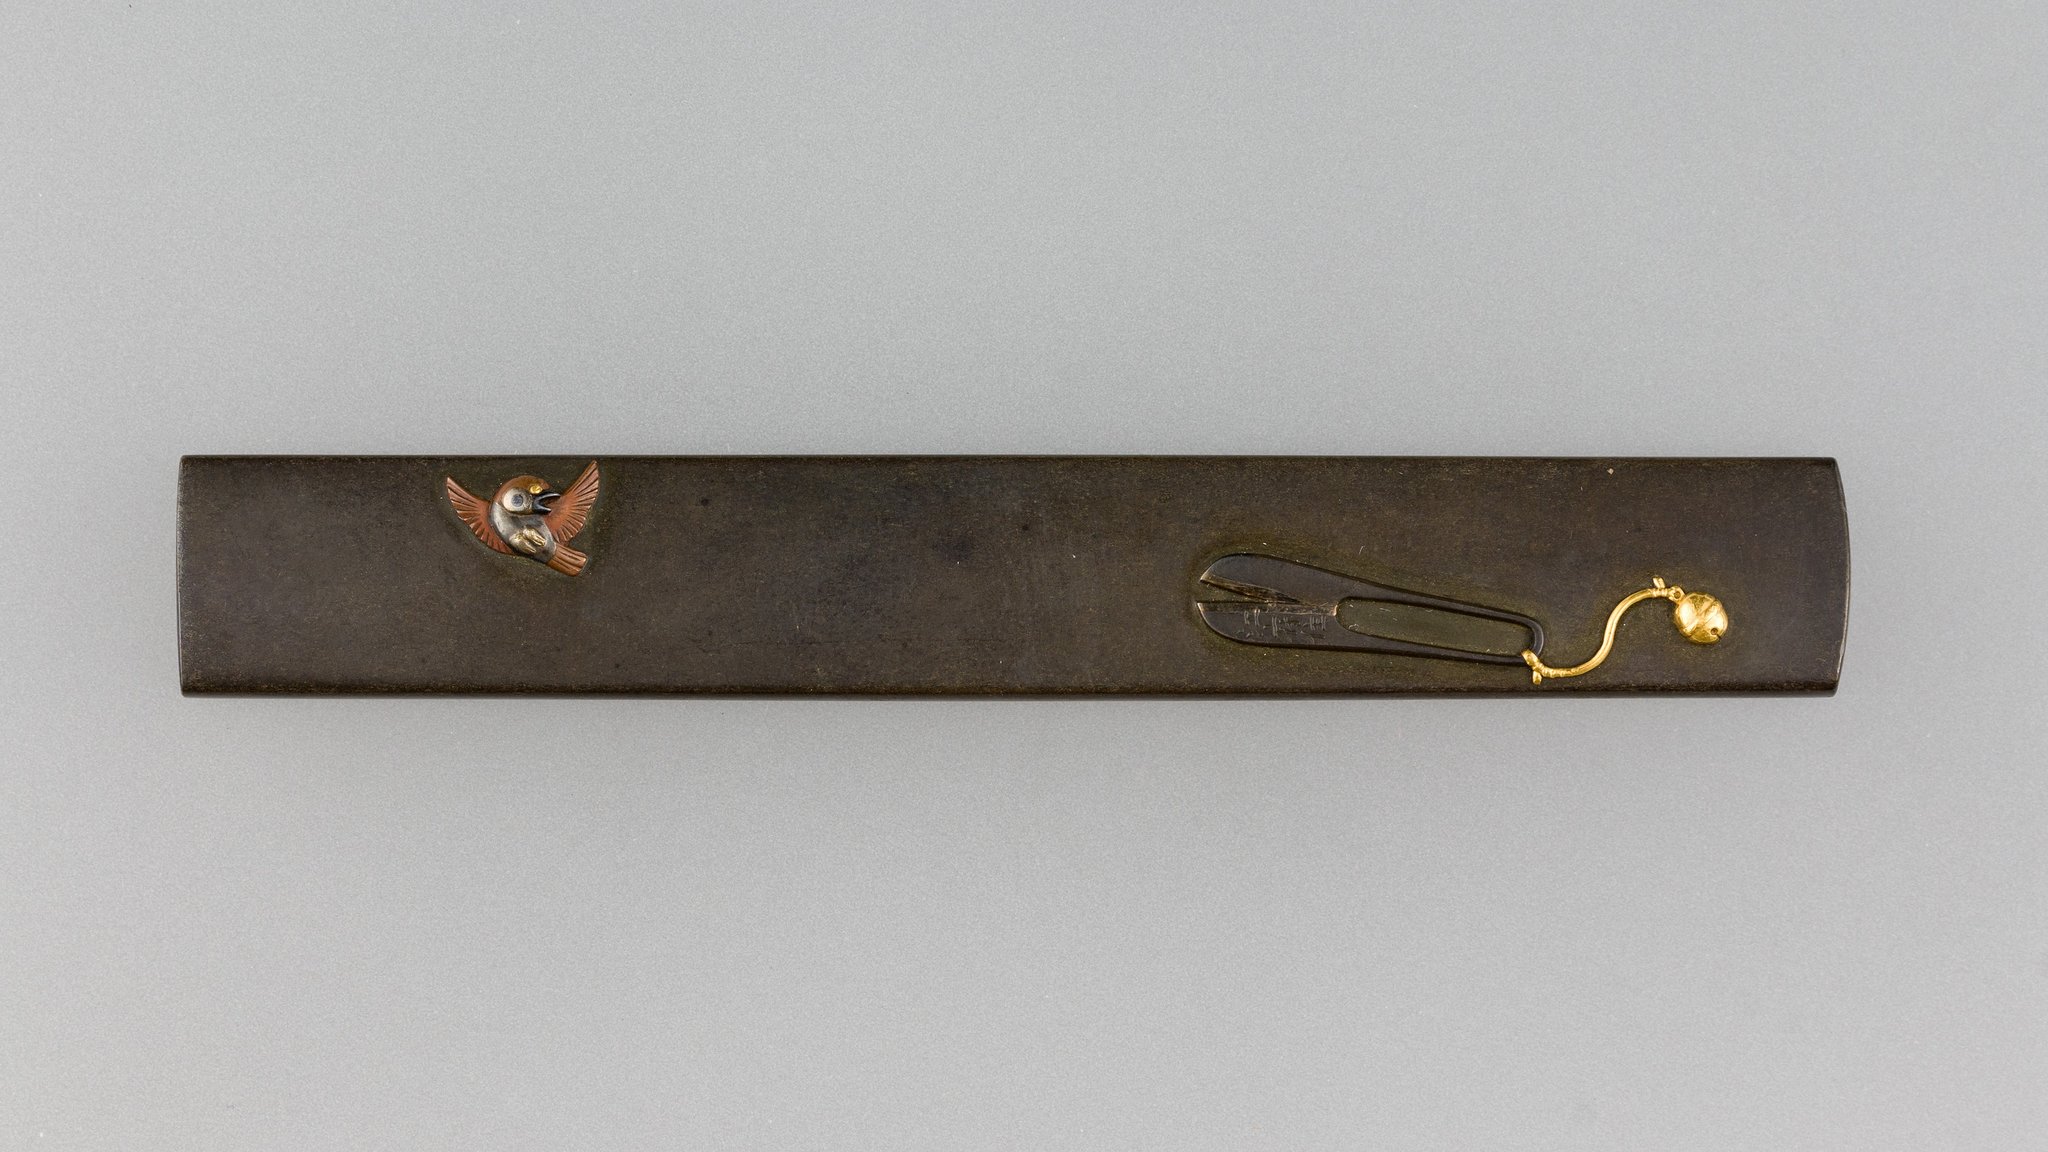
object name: knife handle kozuka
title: Knife Handle (Kozuka)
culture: japanese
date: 1701-1800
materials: copper, silver alloy, gold, silver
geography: japan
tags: birds